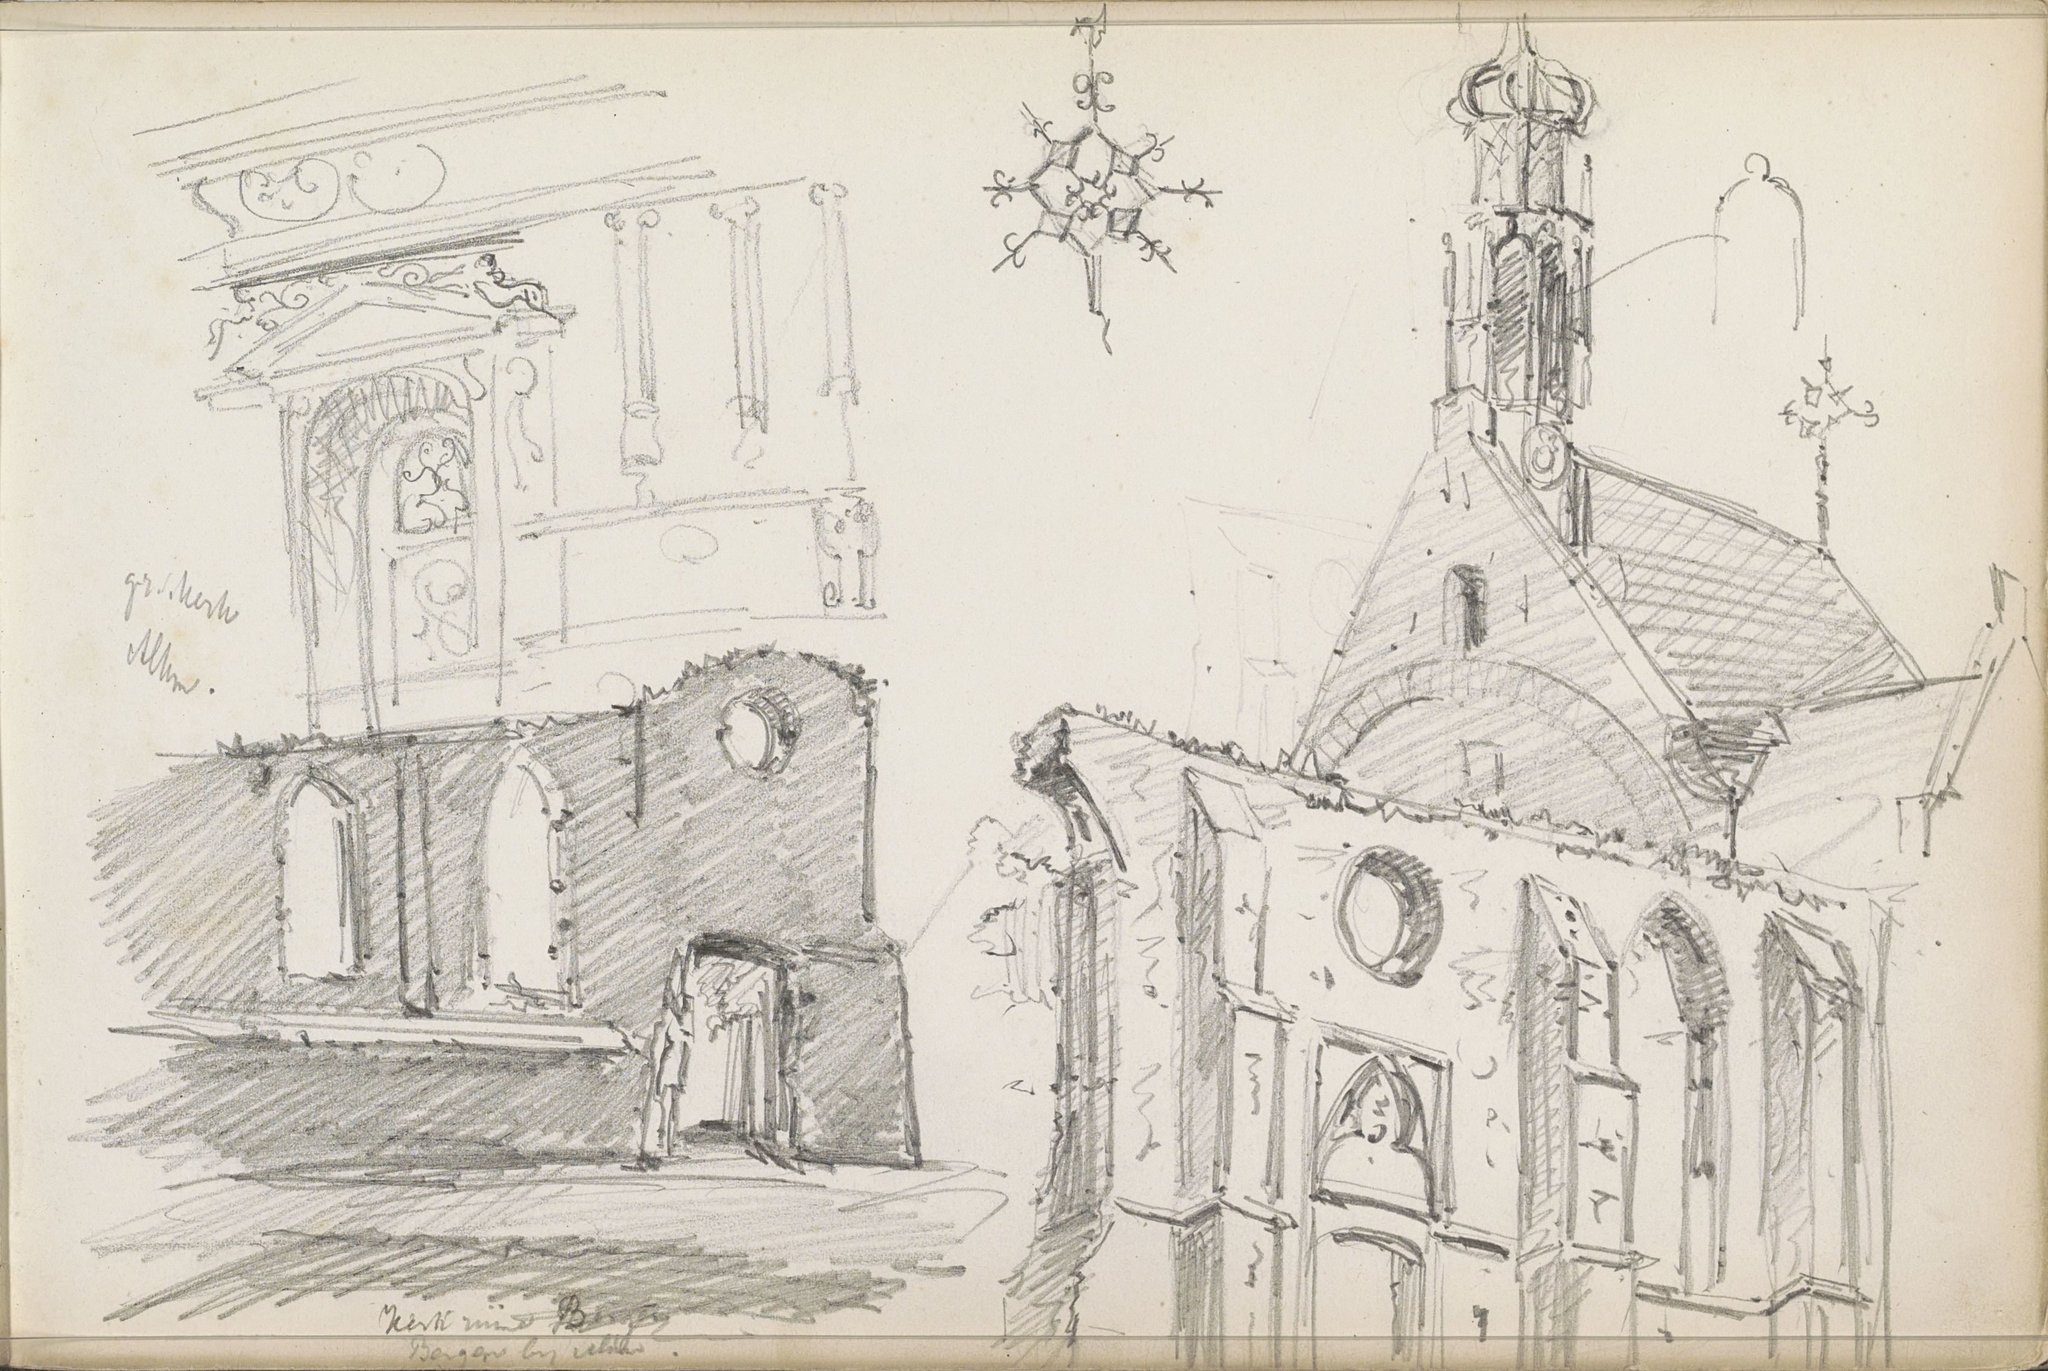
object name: sketchbook leaf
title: Kerkruïne te Bergen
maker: isaac gosschalk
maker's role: draughtsman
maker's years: 1838-1907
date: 1862-1867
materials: paper, pencil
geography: alkmaar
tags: ruin of church, monastery, etc.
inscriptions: annotation: ‘gr kerk/ Alkmaar/ kerk ruïne Bergen/Bergen bij Alkm.’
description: Tevens een studie van een deel van de Grote Kerk te Alkmaar. Blad 37 recto uit een schetsboek met 58 bladen.